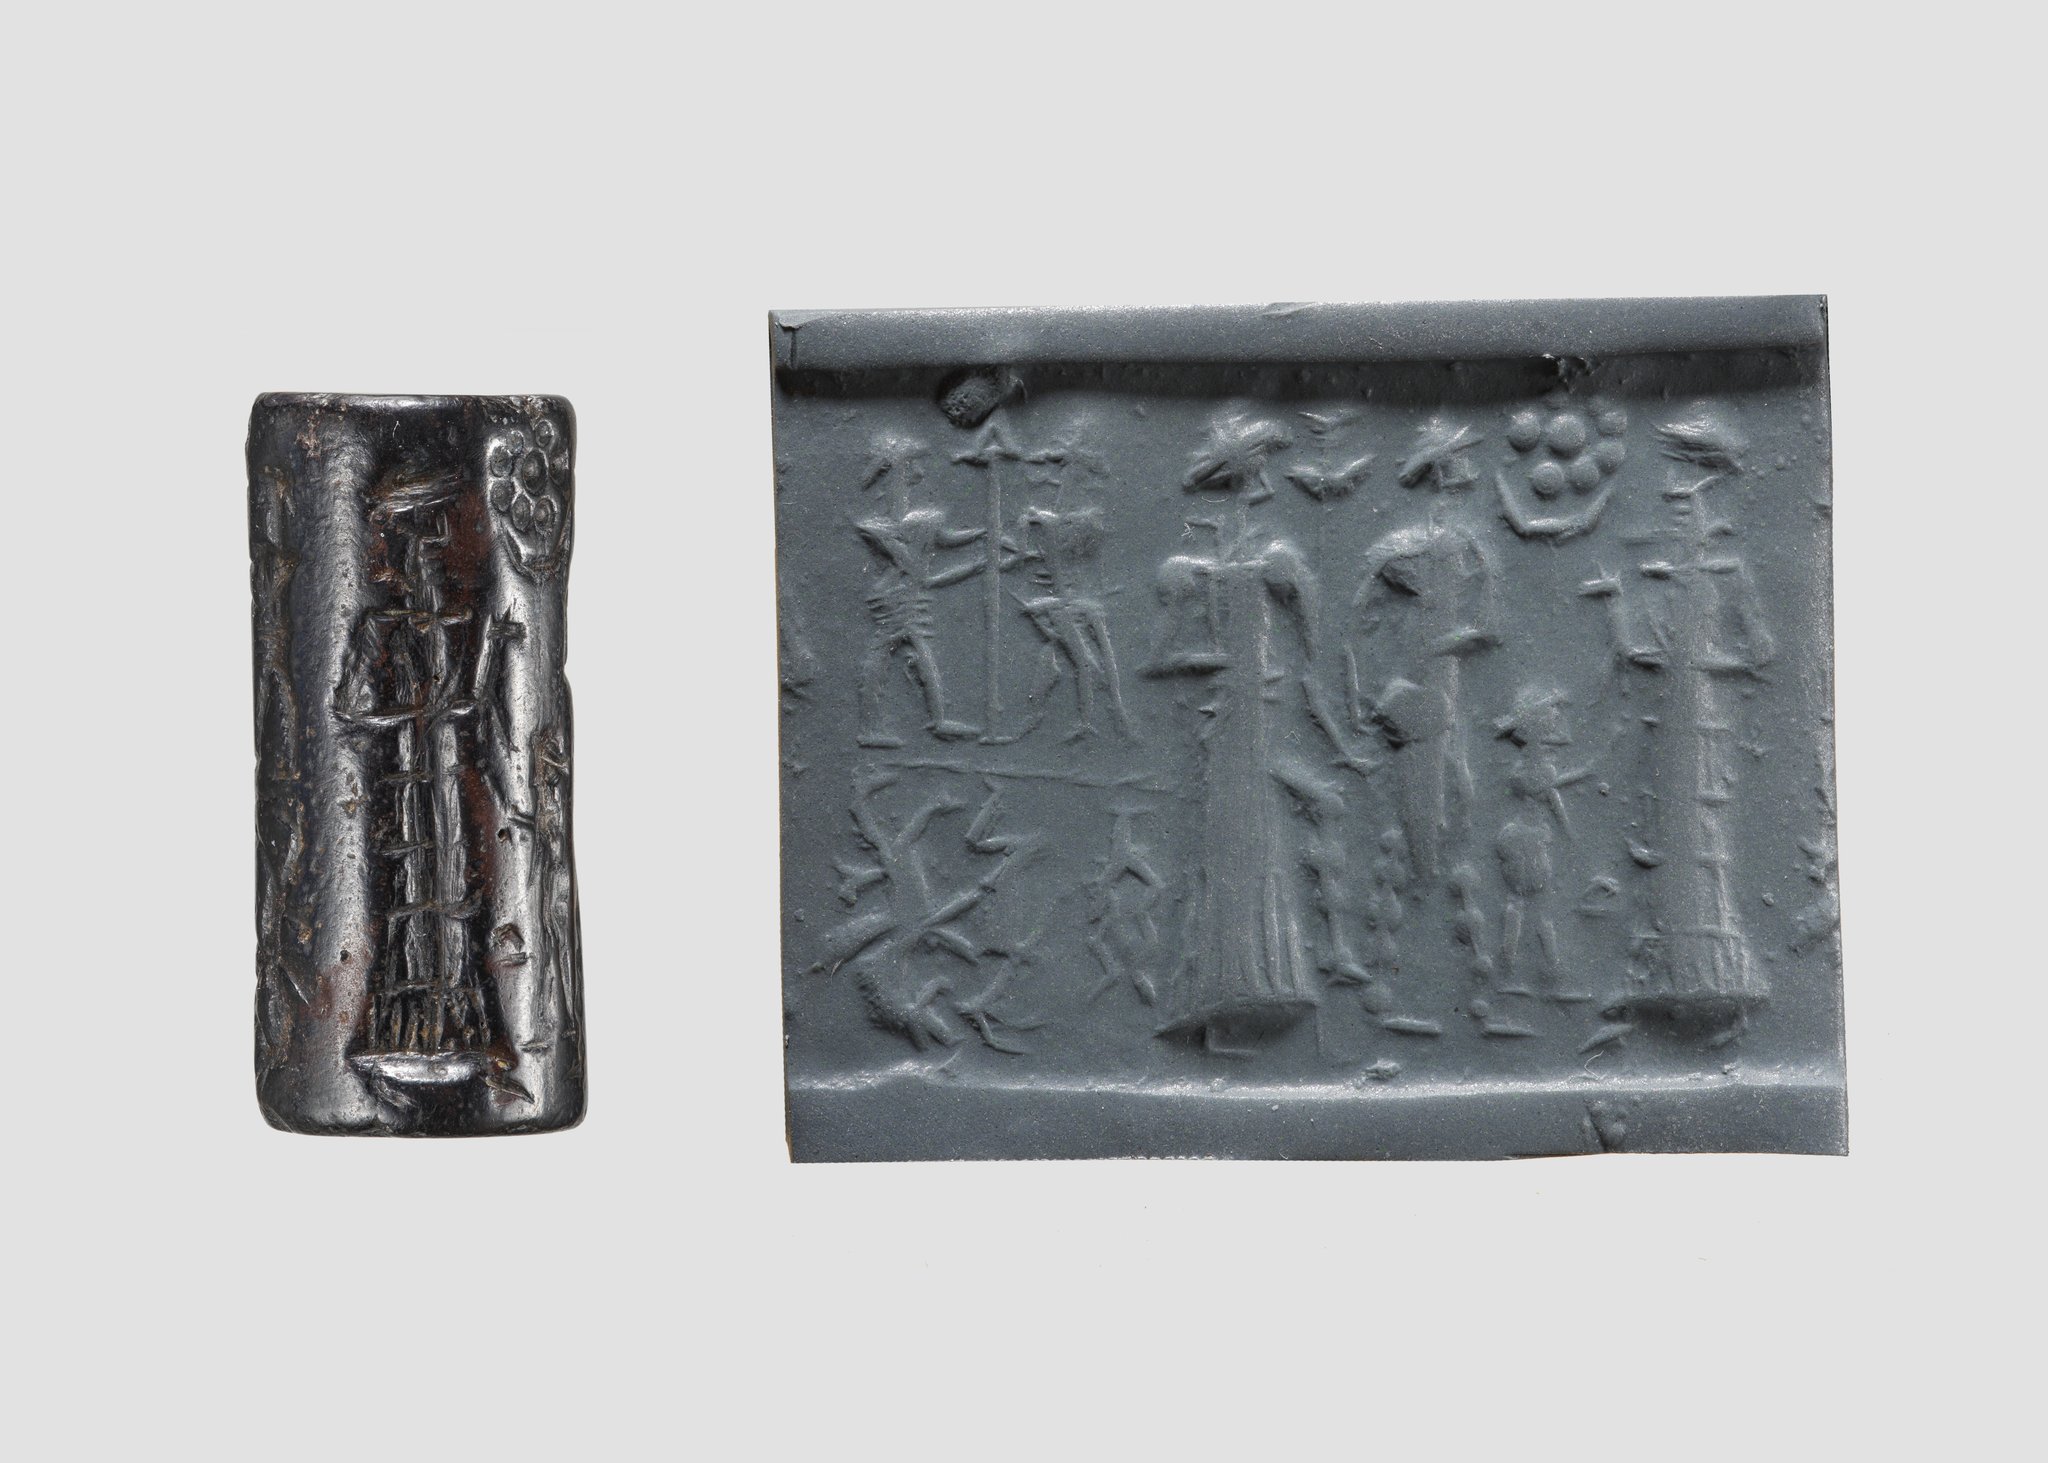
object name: cylinder seal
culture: babylonian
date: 2000-1668 BCE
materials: mineral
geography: mesopotamia